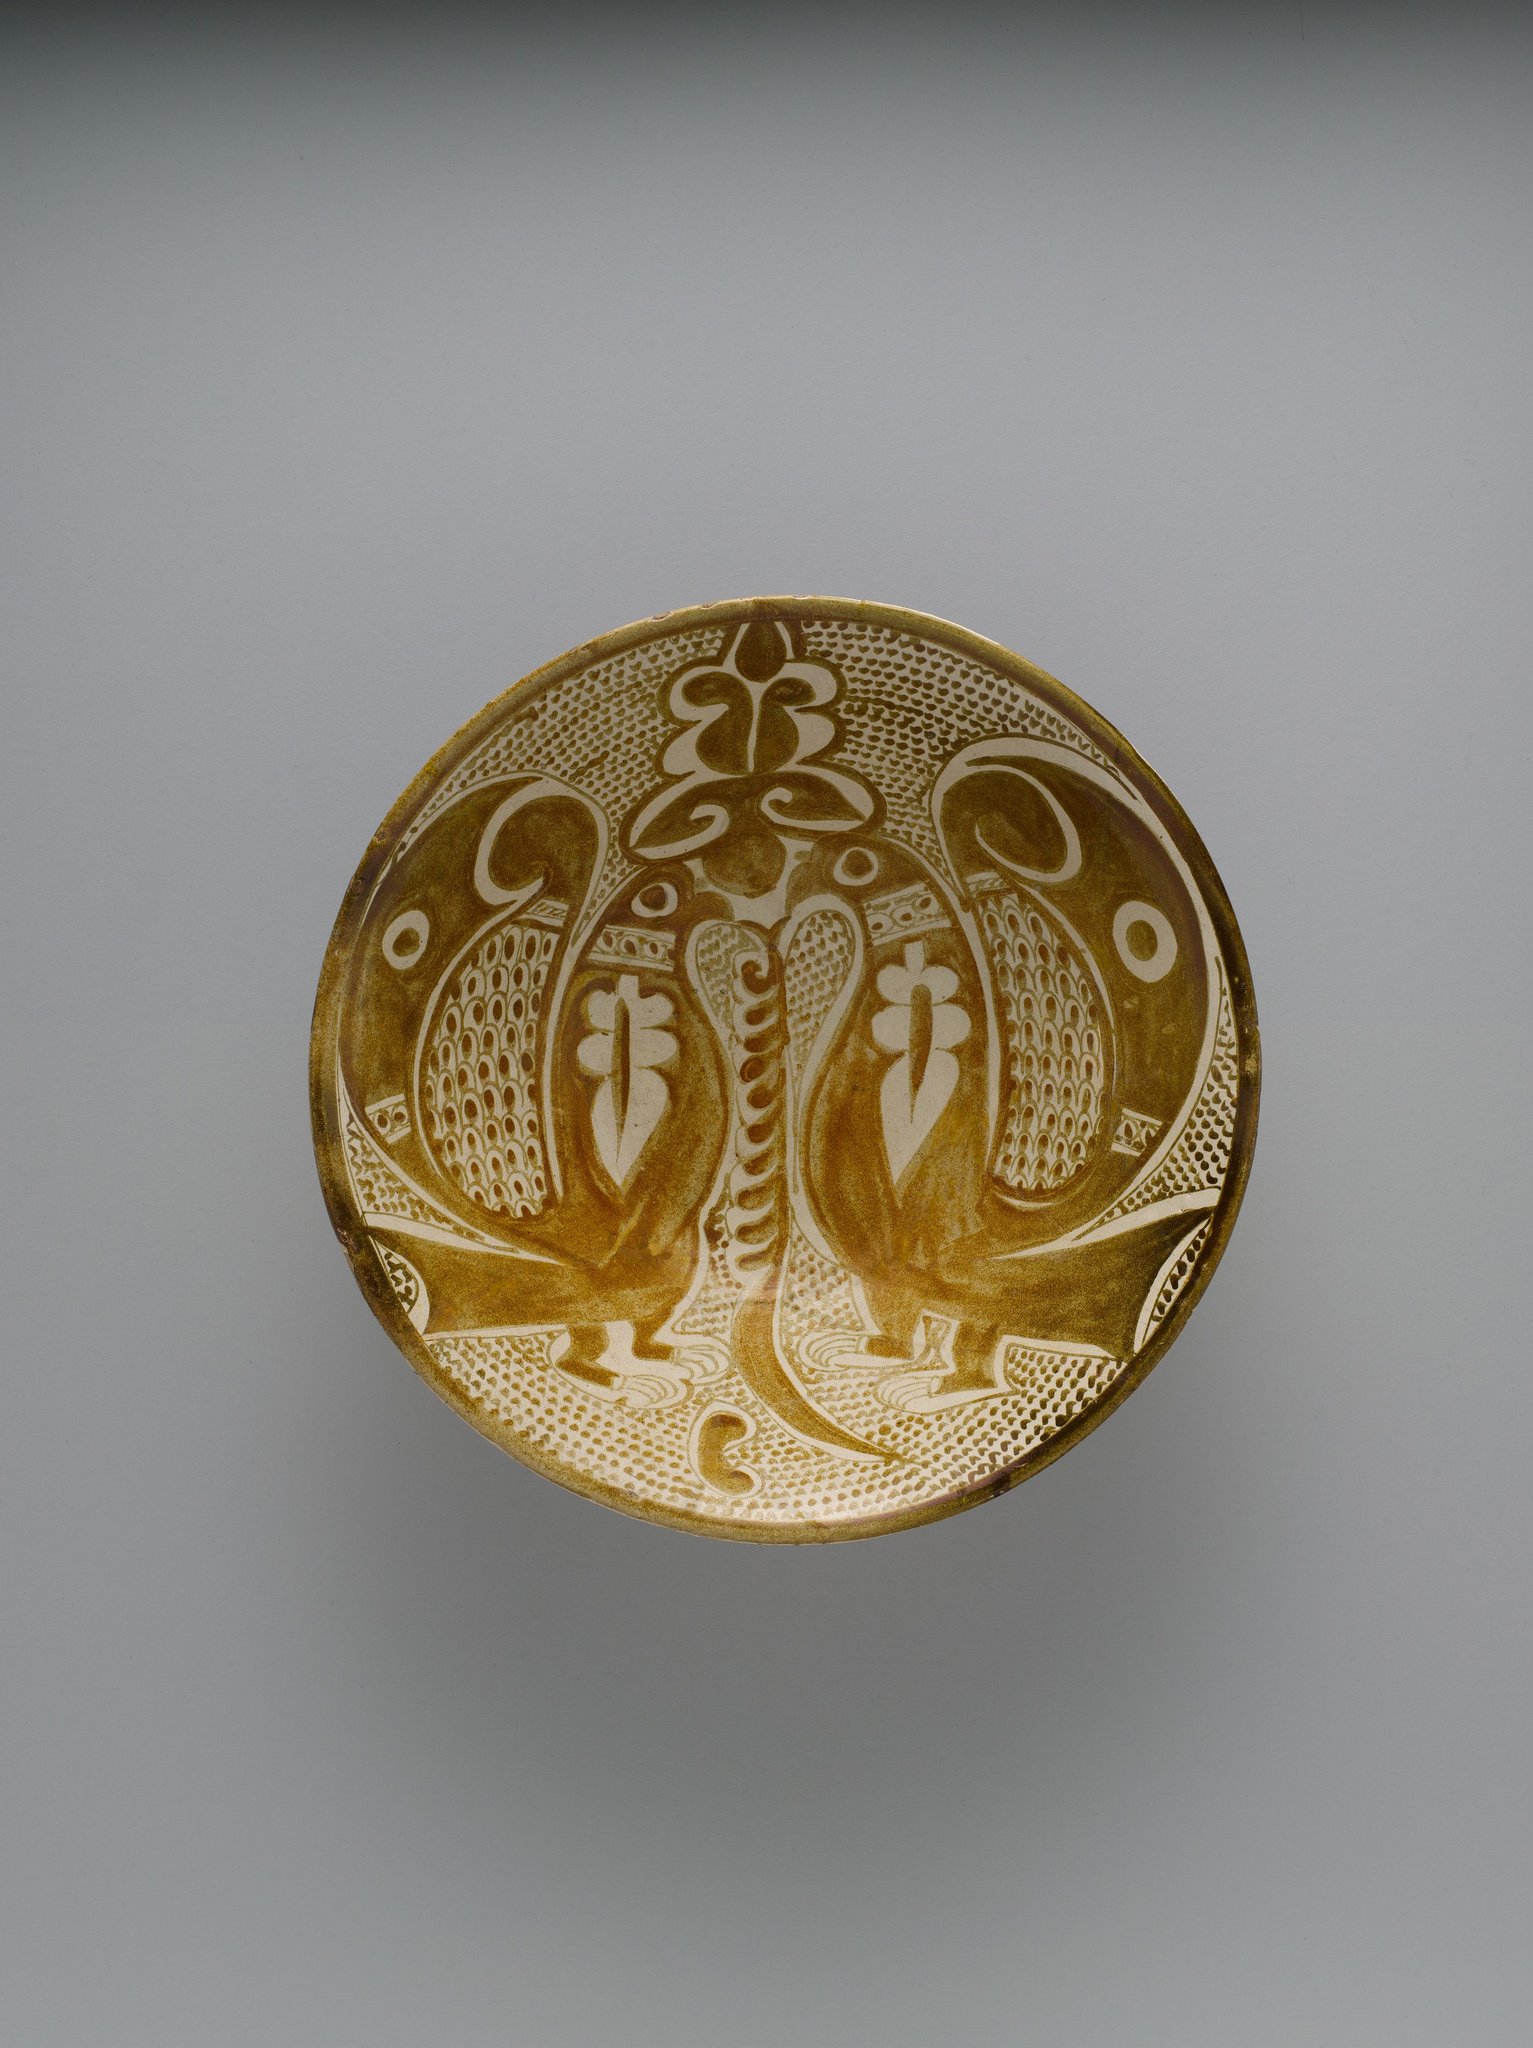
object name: bowl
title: Bowl with Two Facing Peacocks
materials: earthenware, glaze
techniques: luster painting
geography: iraq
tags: peacocks